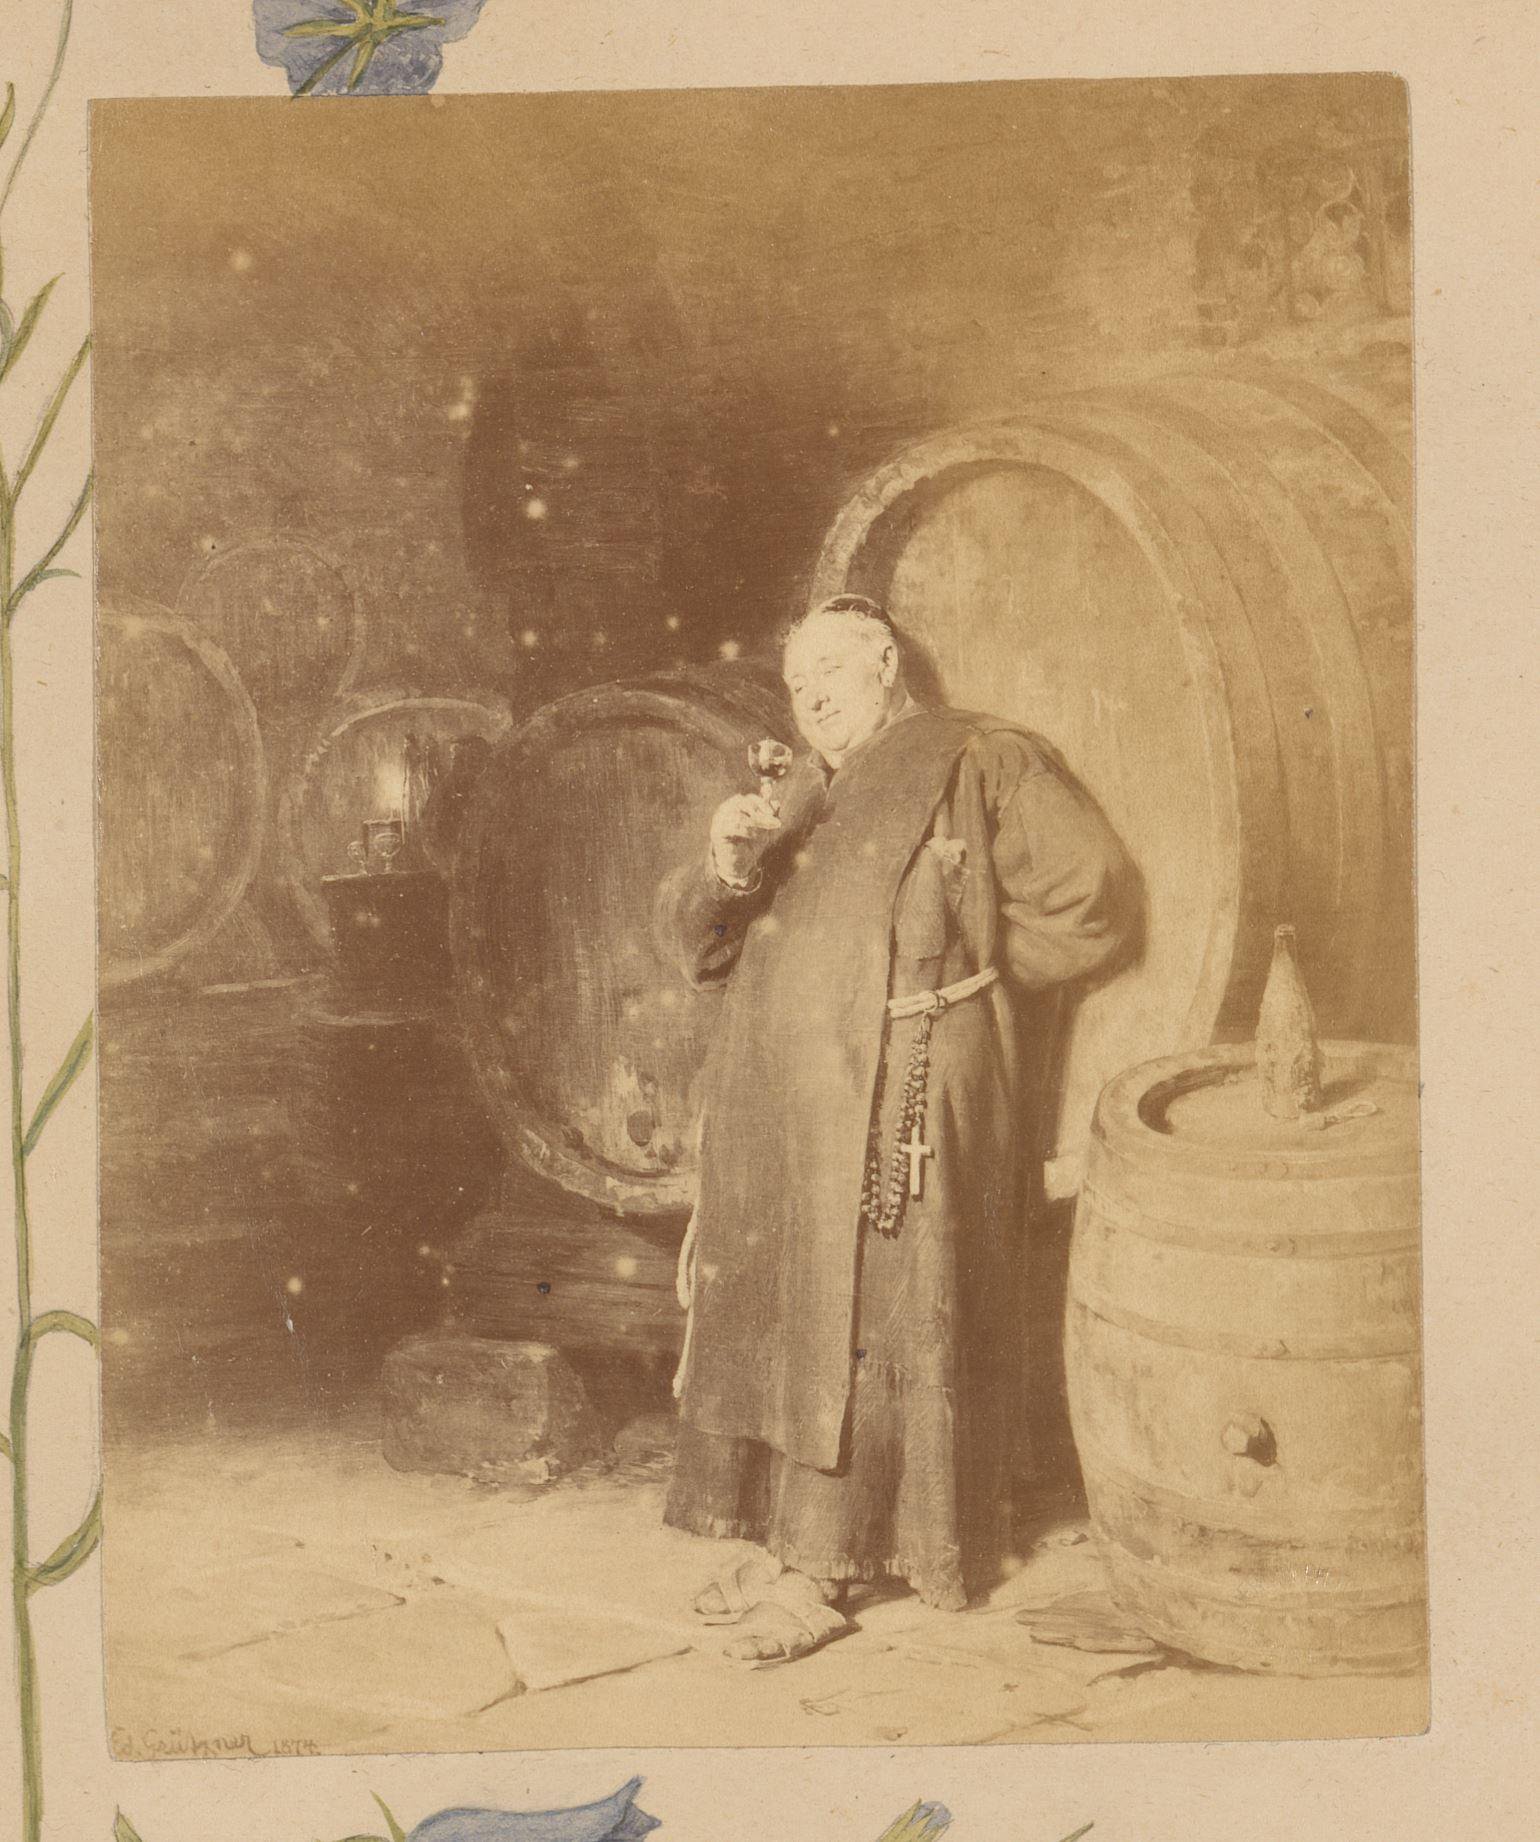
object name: photograph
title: Fotoreproductie van een schilderij met een monnik die wijn drinkt in een wijnkelder naar Eduard Grützner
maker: Anonymous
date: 1875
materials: paper, photographic support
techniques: albumen print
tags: wine-vault, 'cave', monk(s), friar(s)